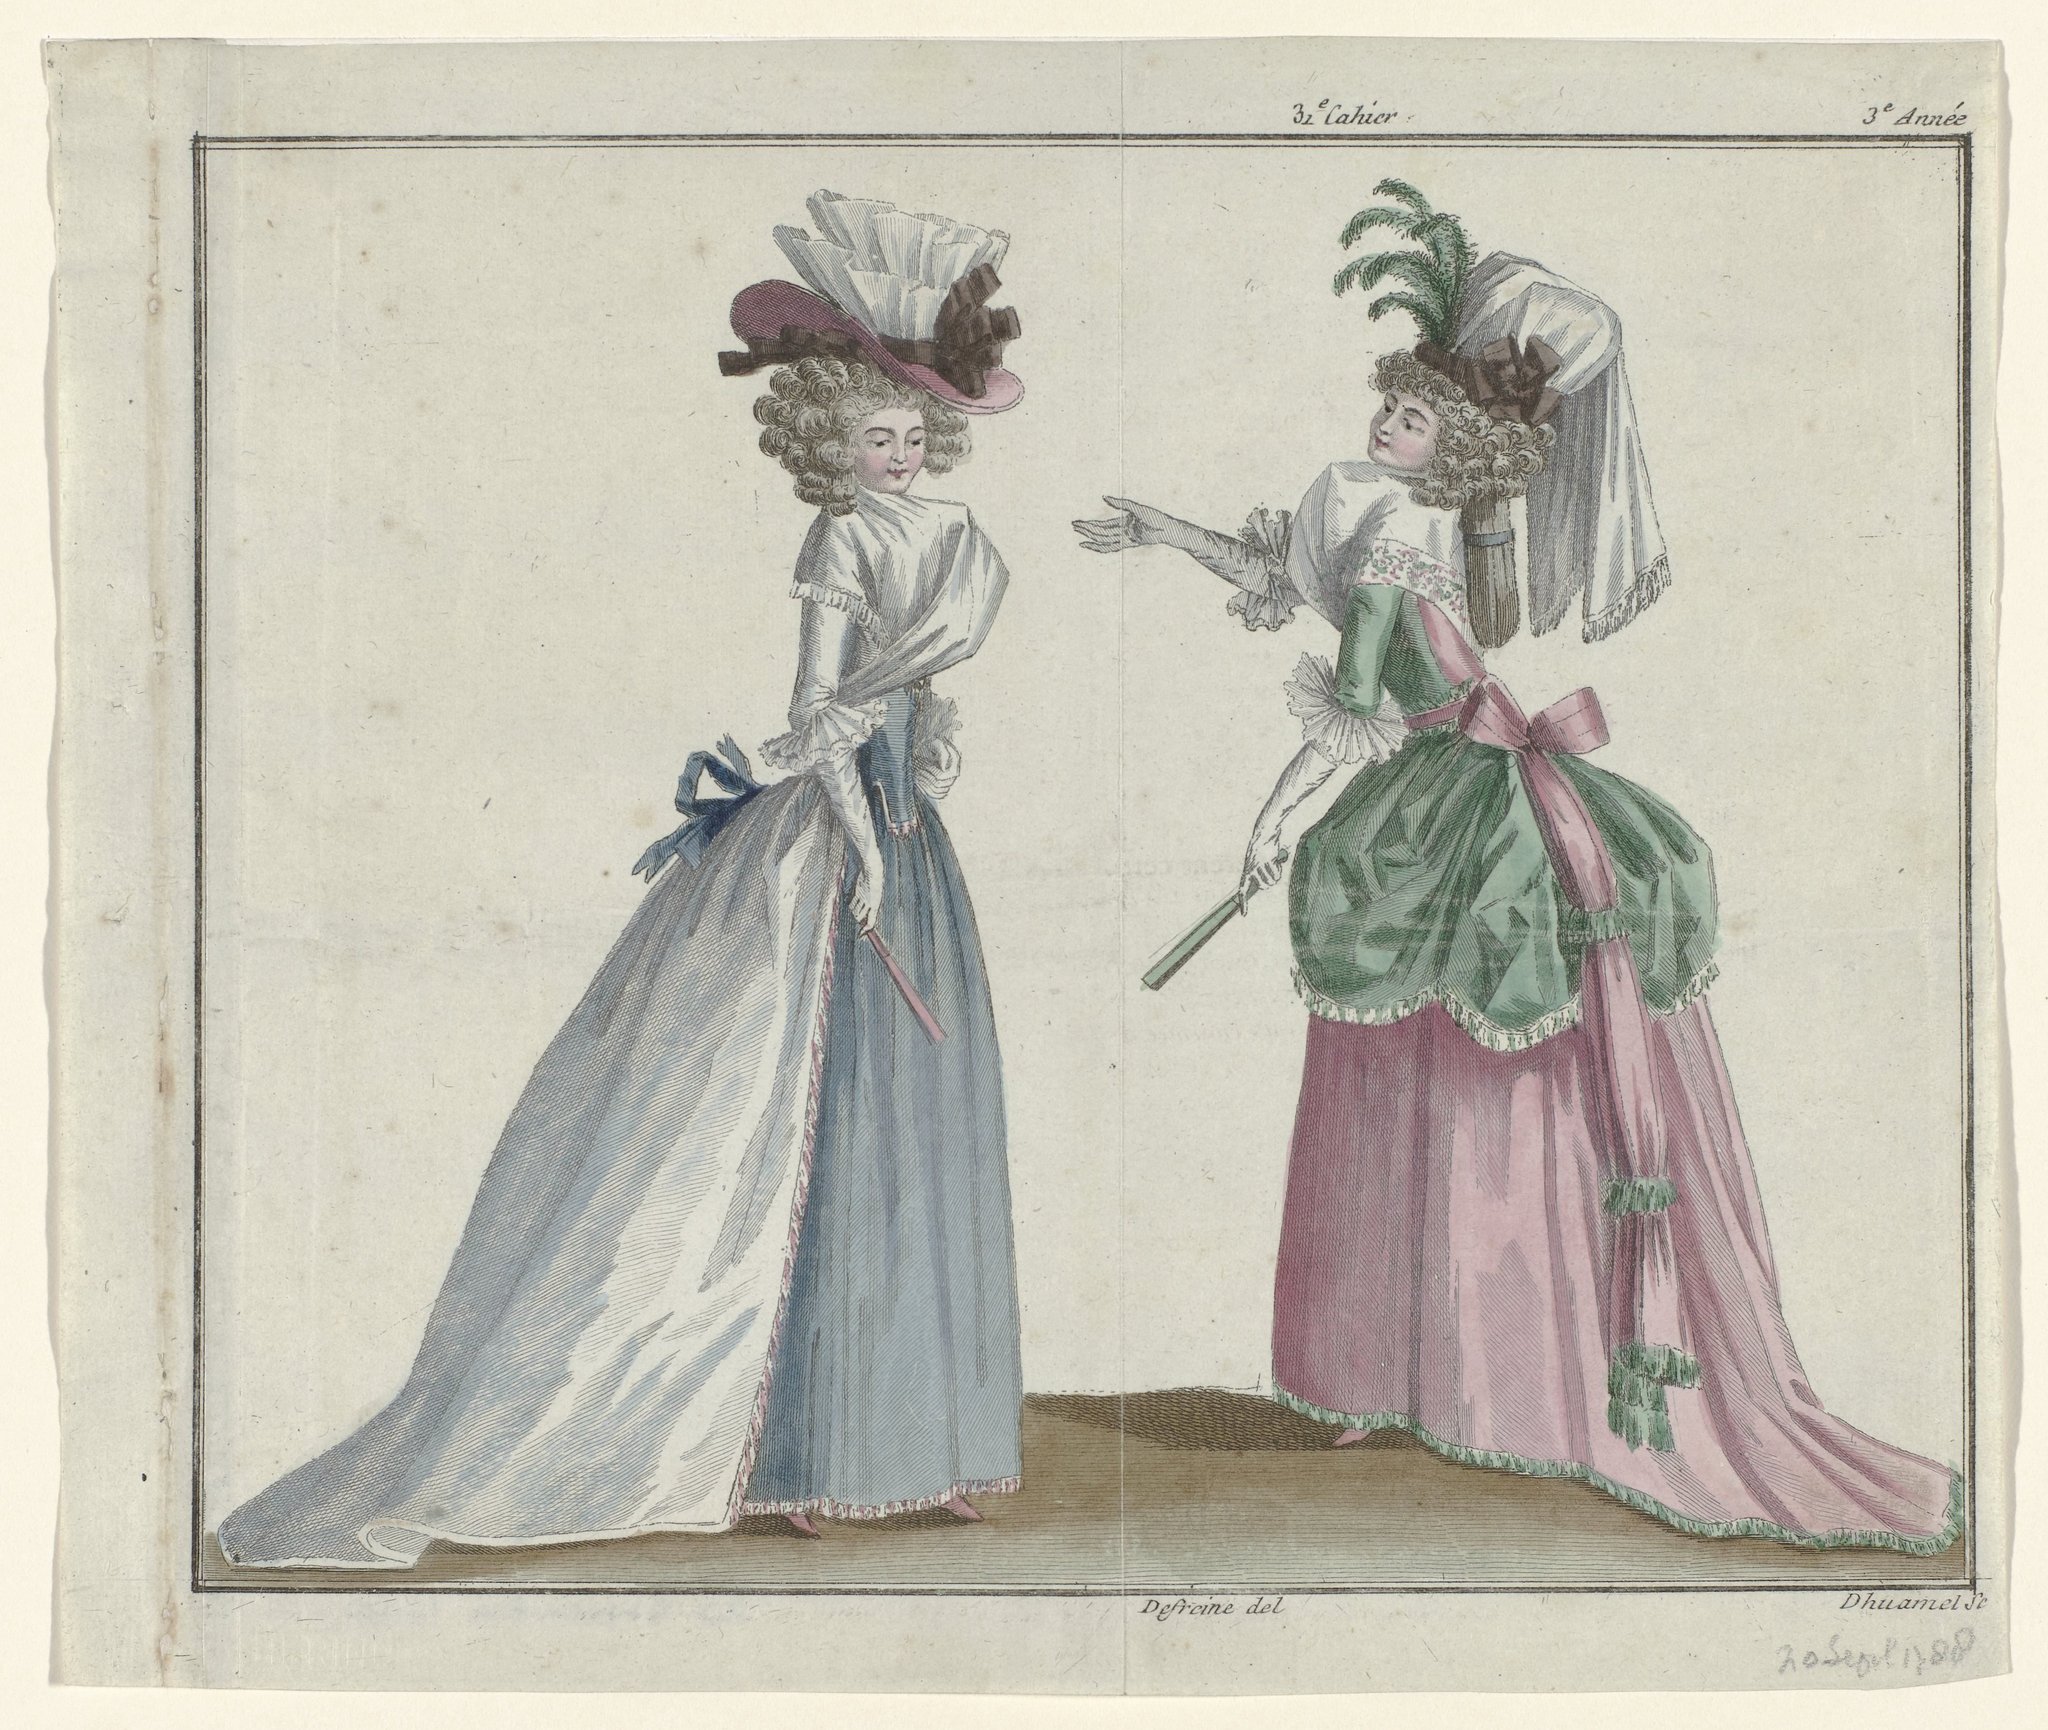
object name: fashion print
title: The First Fashion Magazine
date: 1788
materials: paper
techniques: engraving, hand coloring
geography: paris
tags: styles of hairdress - aa - ~ women, fashion plates, head-gear: hat (+ women's clothes), skirt (+ women's clothes), gloves, mittens, etc. (+ women's clothes), dress, gown (+ women's clothes), fan (+ women's clothes), piece of clothing covering the breast or décolleté (fichu) (+ women's clothes), underclothes for the upper part of the body: corset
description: The Cabinet des Modes ou les Modes Nouvelles first appeared on 15 November 1785. As the first real fashion magazine, it was published on a regular basis and wholly dedicated to news from the world of fashion. It was available by subscription only and distributed both in France and abroad. Each eight-page edition contained three hand-coloured engravings. After a year in print, the magazine changed its name to Magasin des Modes Nouvelles Françaises et Anglaises. Instead of three loose sheets, it now included a single fold-out plate depicting clothes and accessories. Publication of the Magasin ceased abruptly in 1789; after this, it was most likely succeeded by the Journal de la Mode et du Goût.